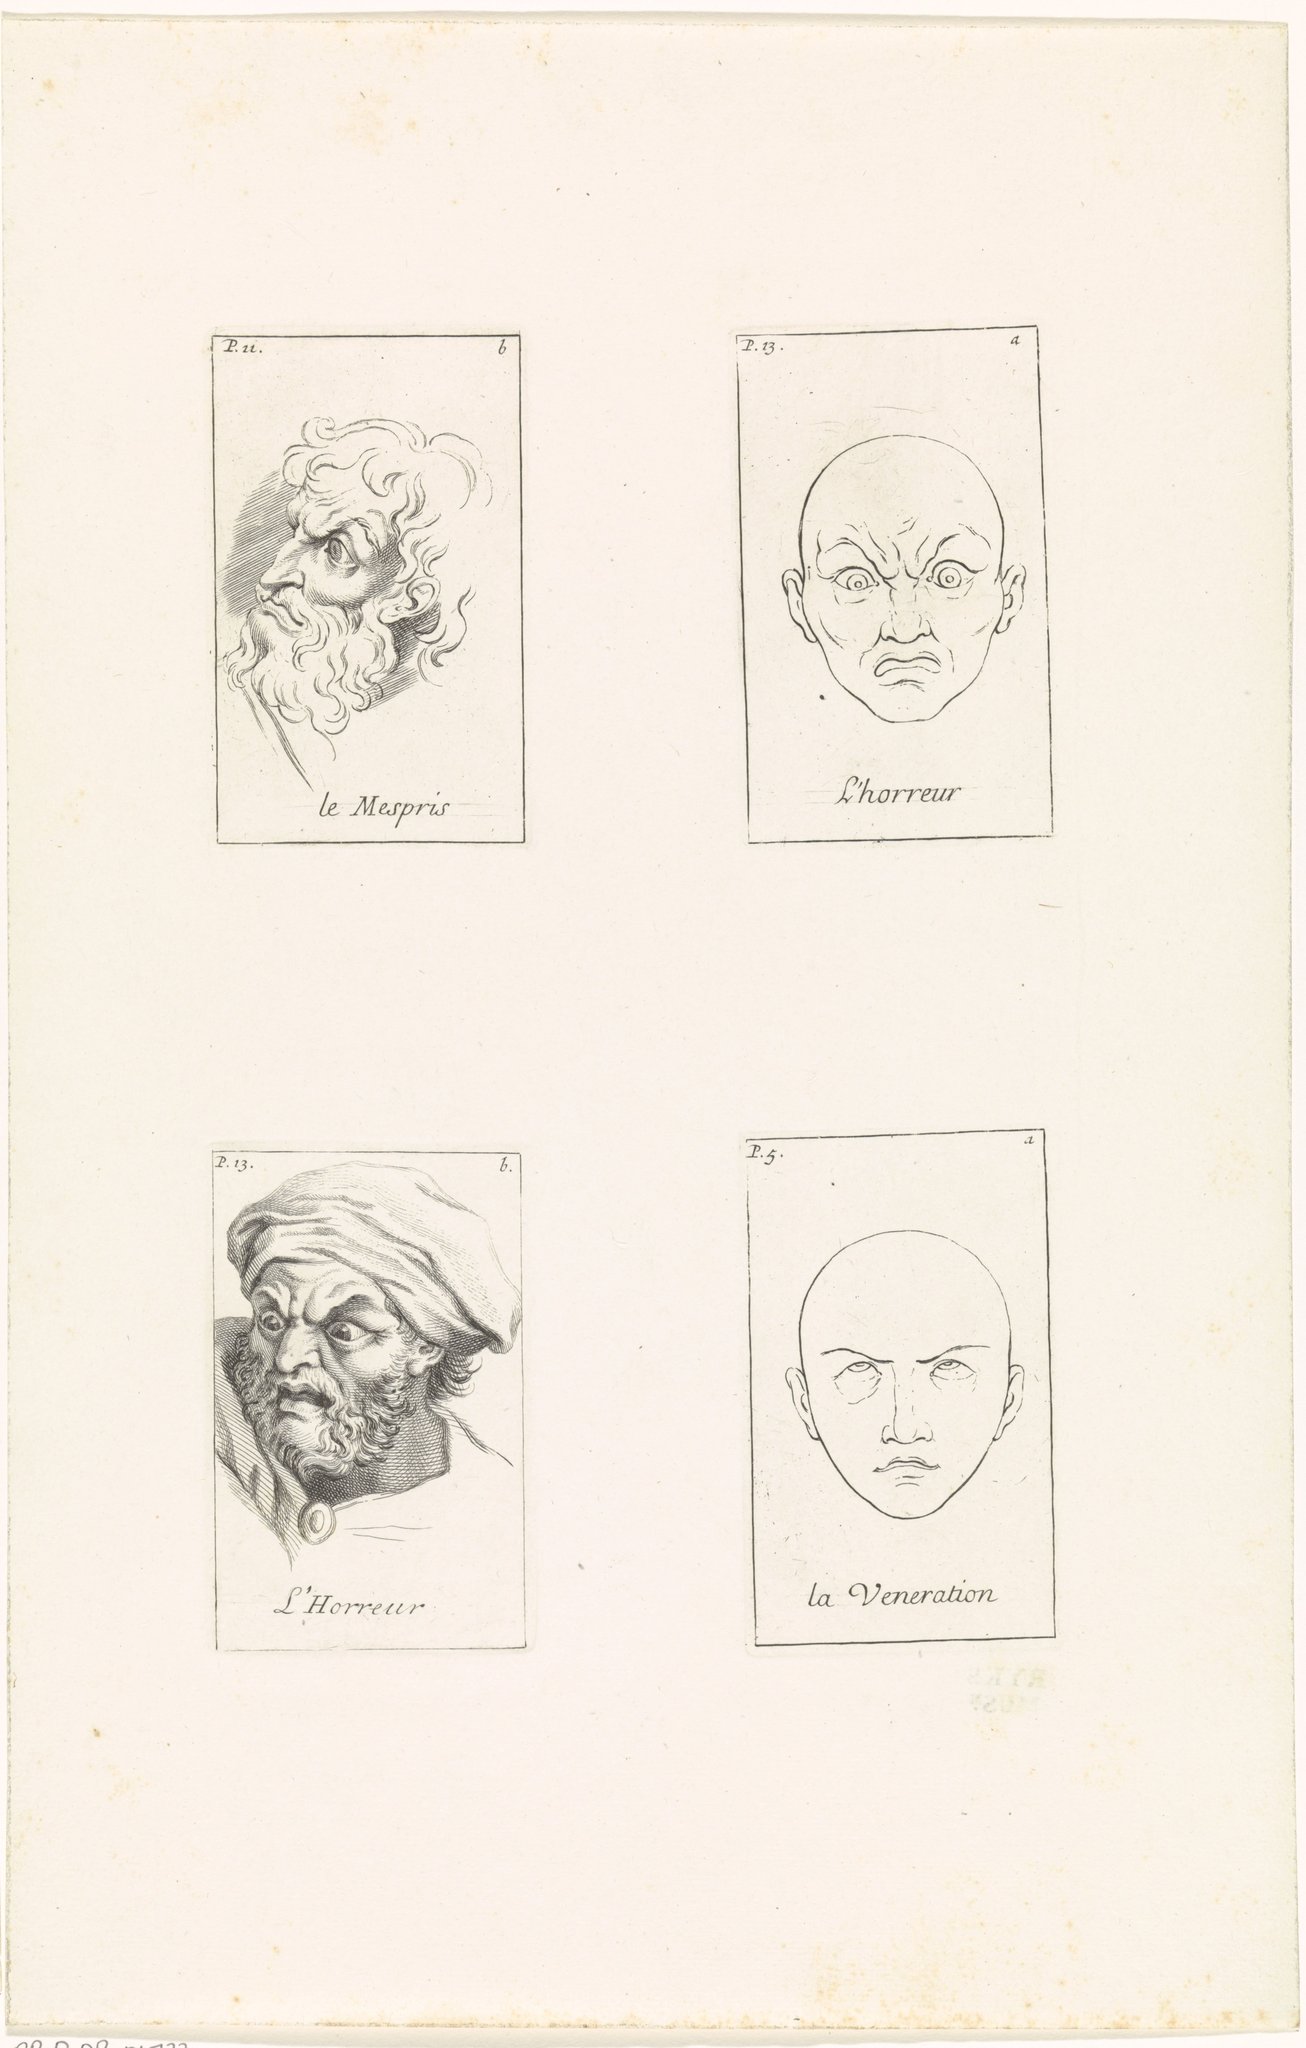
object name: book illustration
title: Voorstellingen van verschillende emoties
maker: bernard picart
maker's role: draughtsman, print maker, publisher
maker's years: 1673-1733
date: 1711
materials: paper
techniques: engraving, etching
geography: amsterdam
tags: morphology of facial expression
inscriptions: collector's mark: Lugt 2165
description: Onversneden blad met vier prenten met voorstellingen van mannenkoppen die verschillende emoties uitdrukken. Van links naar rechts, van boven naar beneden: le Mespris, l'horreur, L'Horreur en la Veneration. De prenten hebben een titel in het Frans en zijn gemerkt met een paginanummer en een letter.